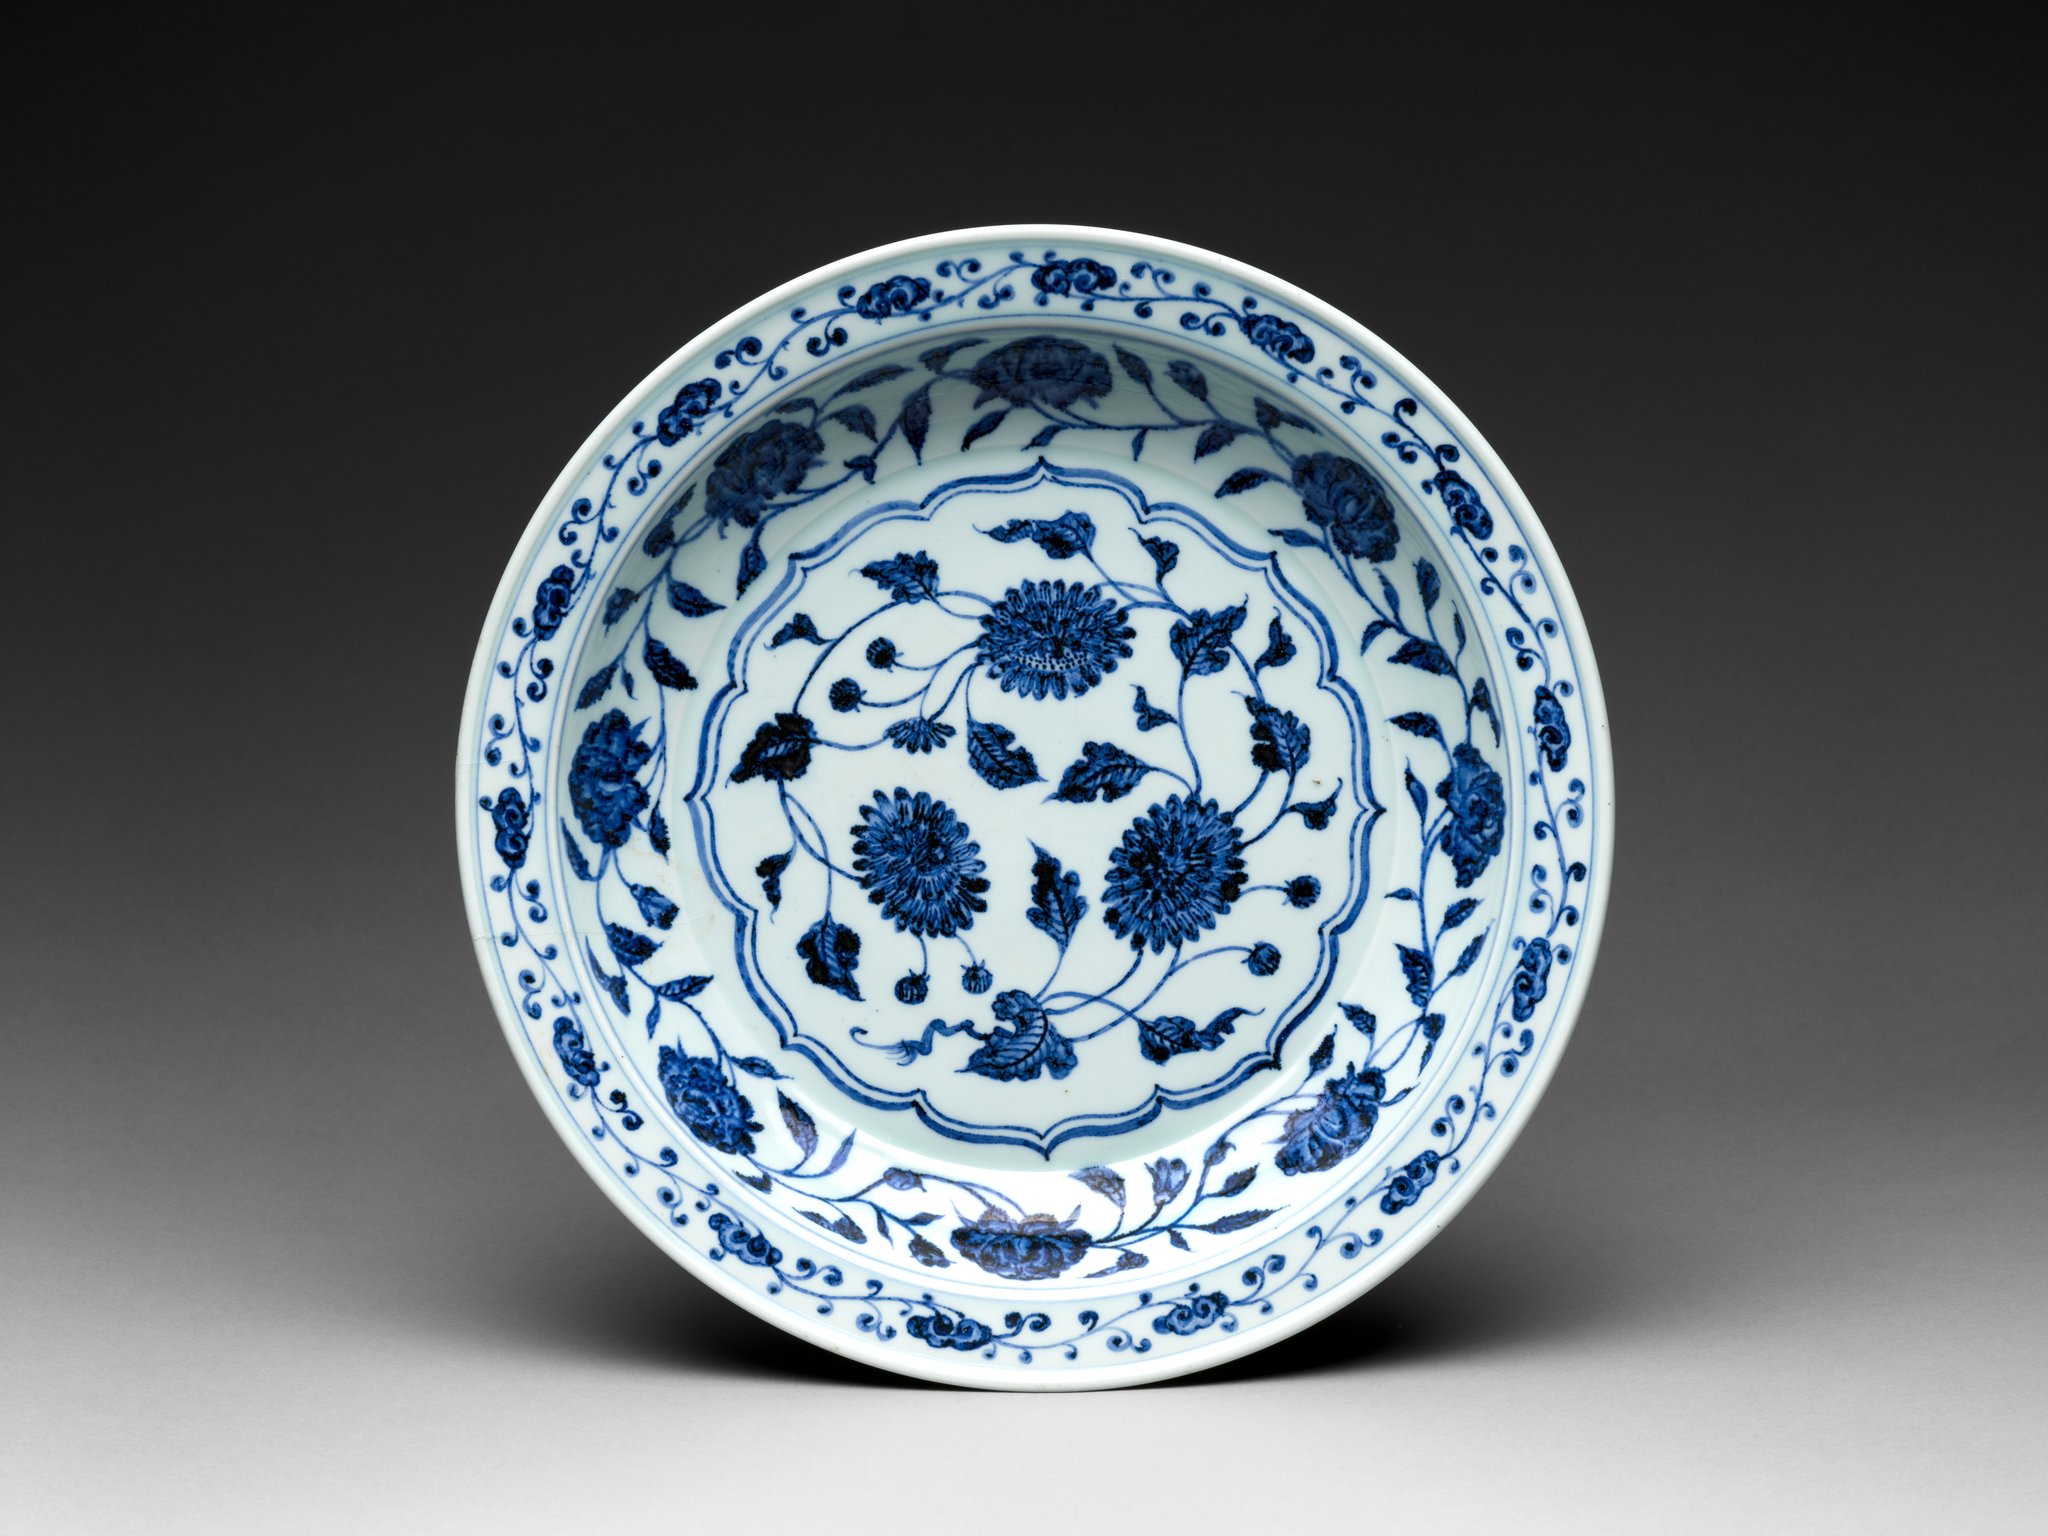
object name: plate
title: Plate with chrysanthemums and peonies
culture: chinese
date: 1401-1500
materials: cobalt, glaze, porcelain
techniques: painting